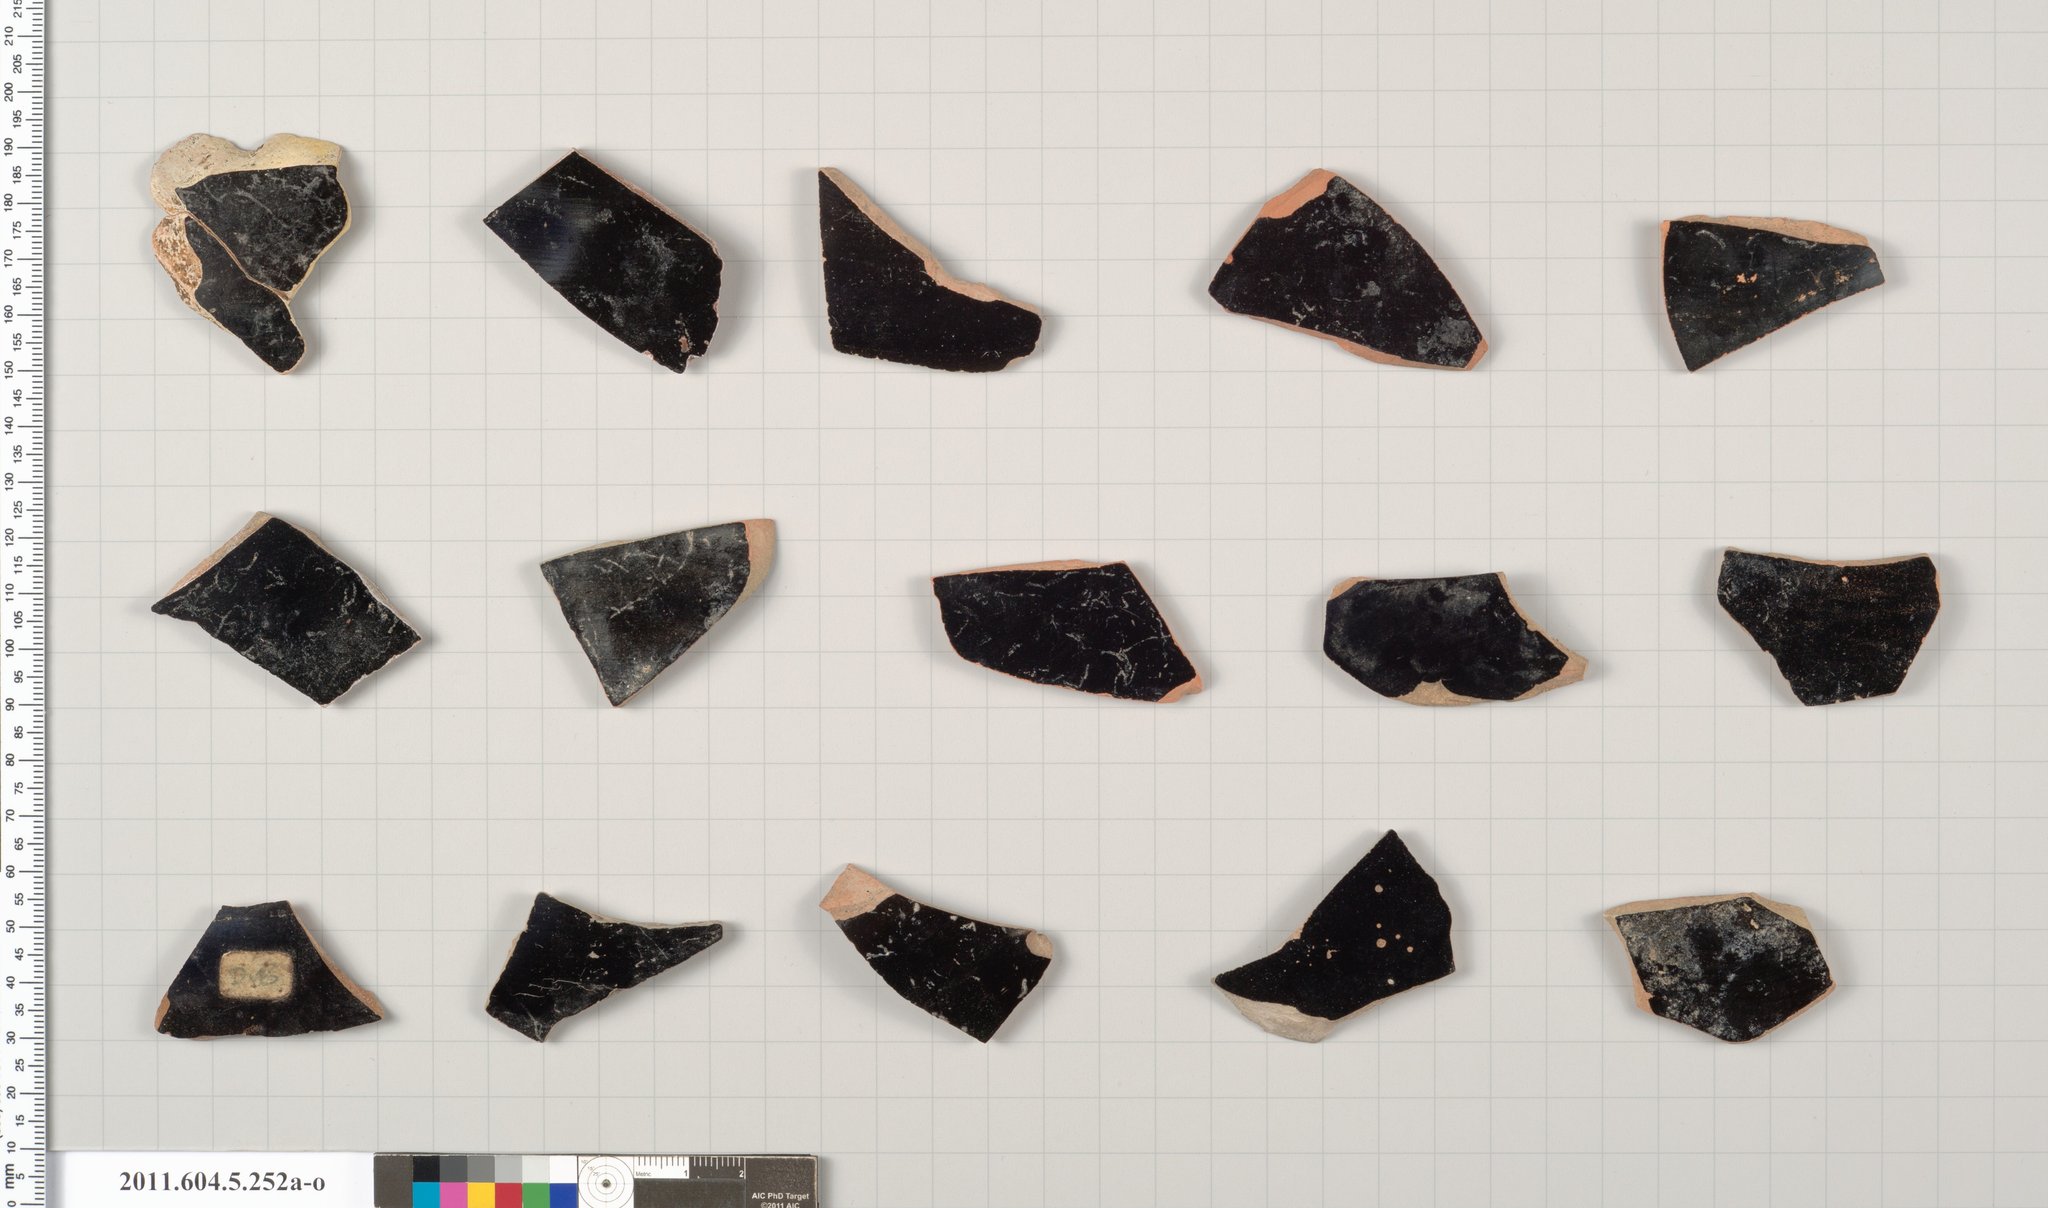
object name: kylix fragment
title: Terracotta fragments of kylikes (drinking cups)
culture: greek, attic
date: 600-401 BCE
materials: terracotta